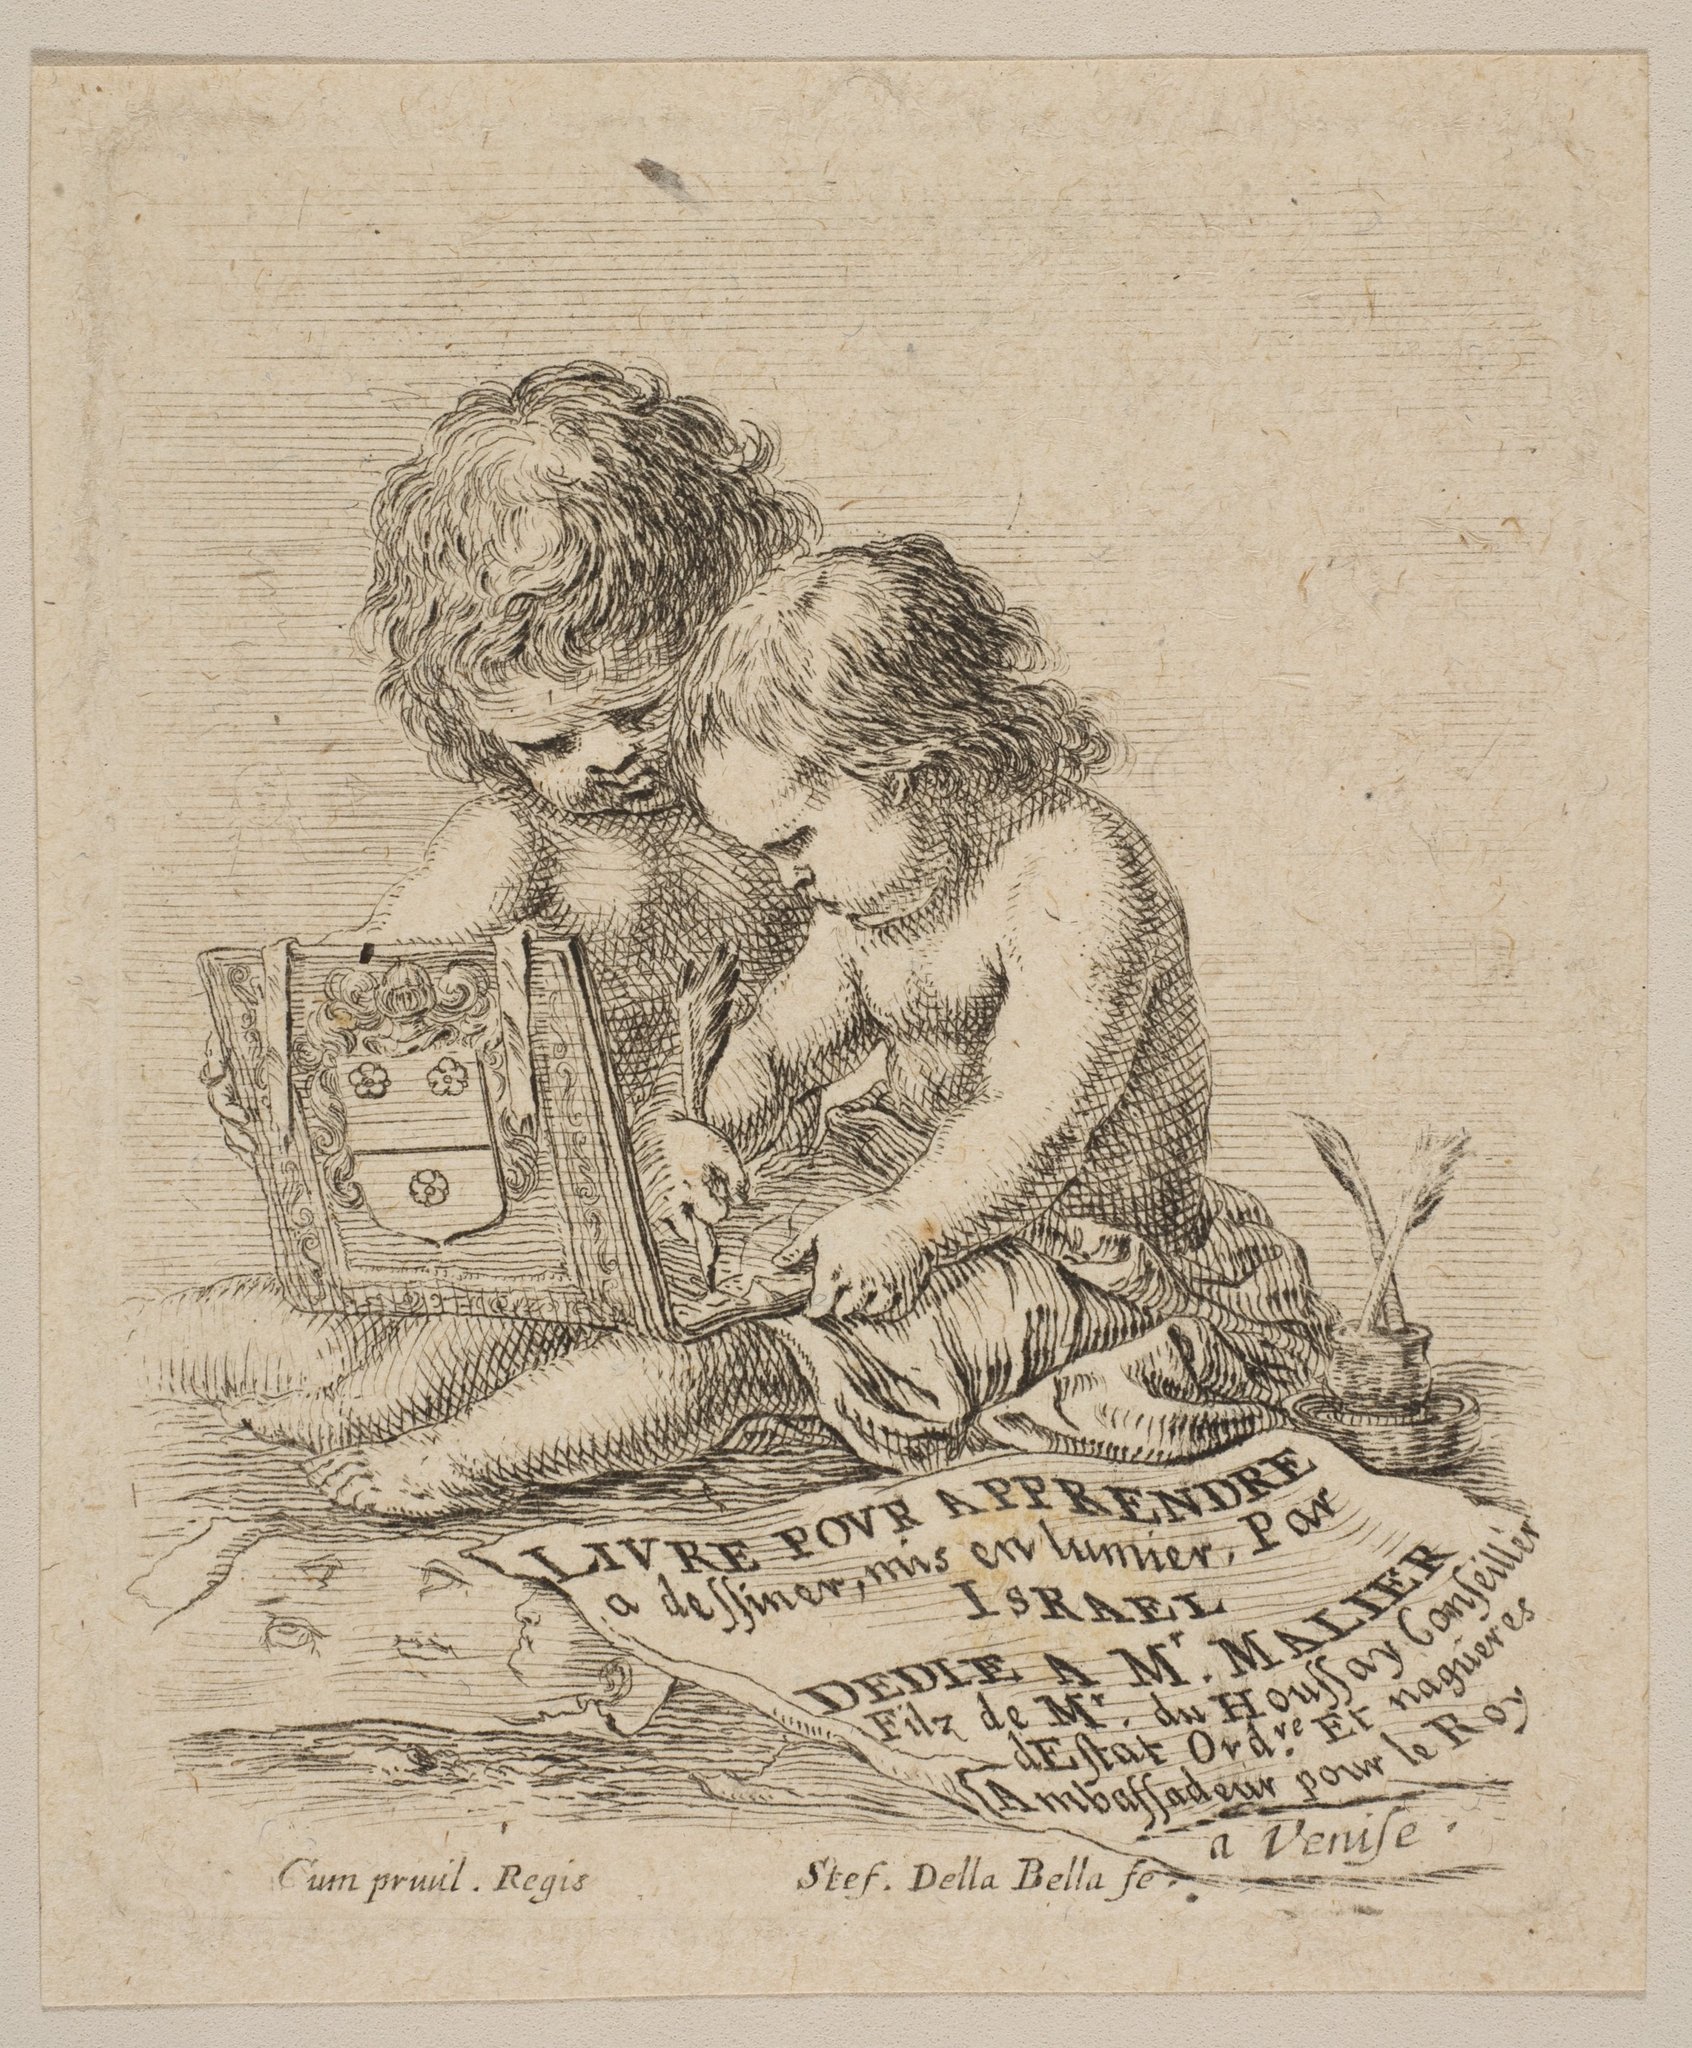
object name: print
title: Plate 1: two children sitting on the ground, the child on the right drawing while the child on the left holding the album, the title page from 'The Book for Learning to Draw' (Livre pour apprendre à dessiner)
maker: stefano della bella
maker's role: artist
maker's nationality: italian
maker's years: 1610-1664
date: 1649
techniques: etching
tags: drawing,children